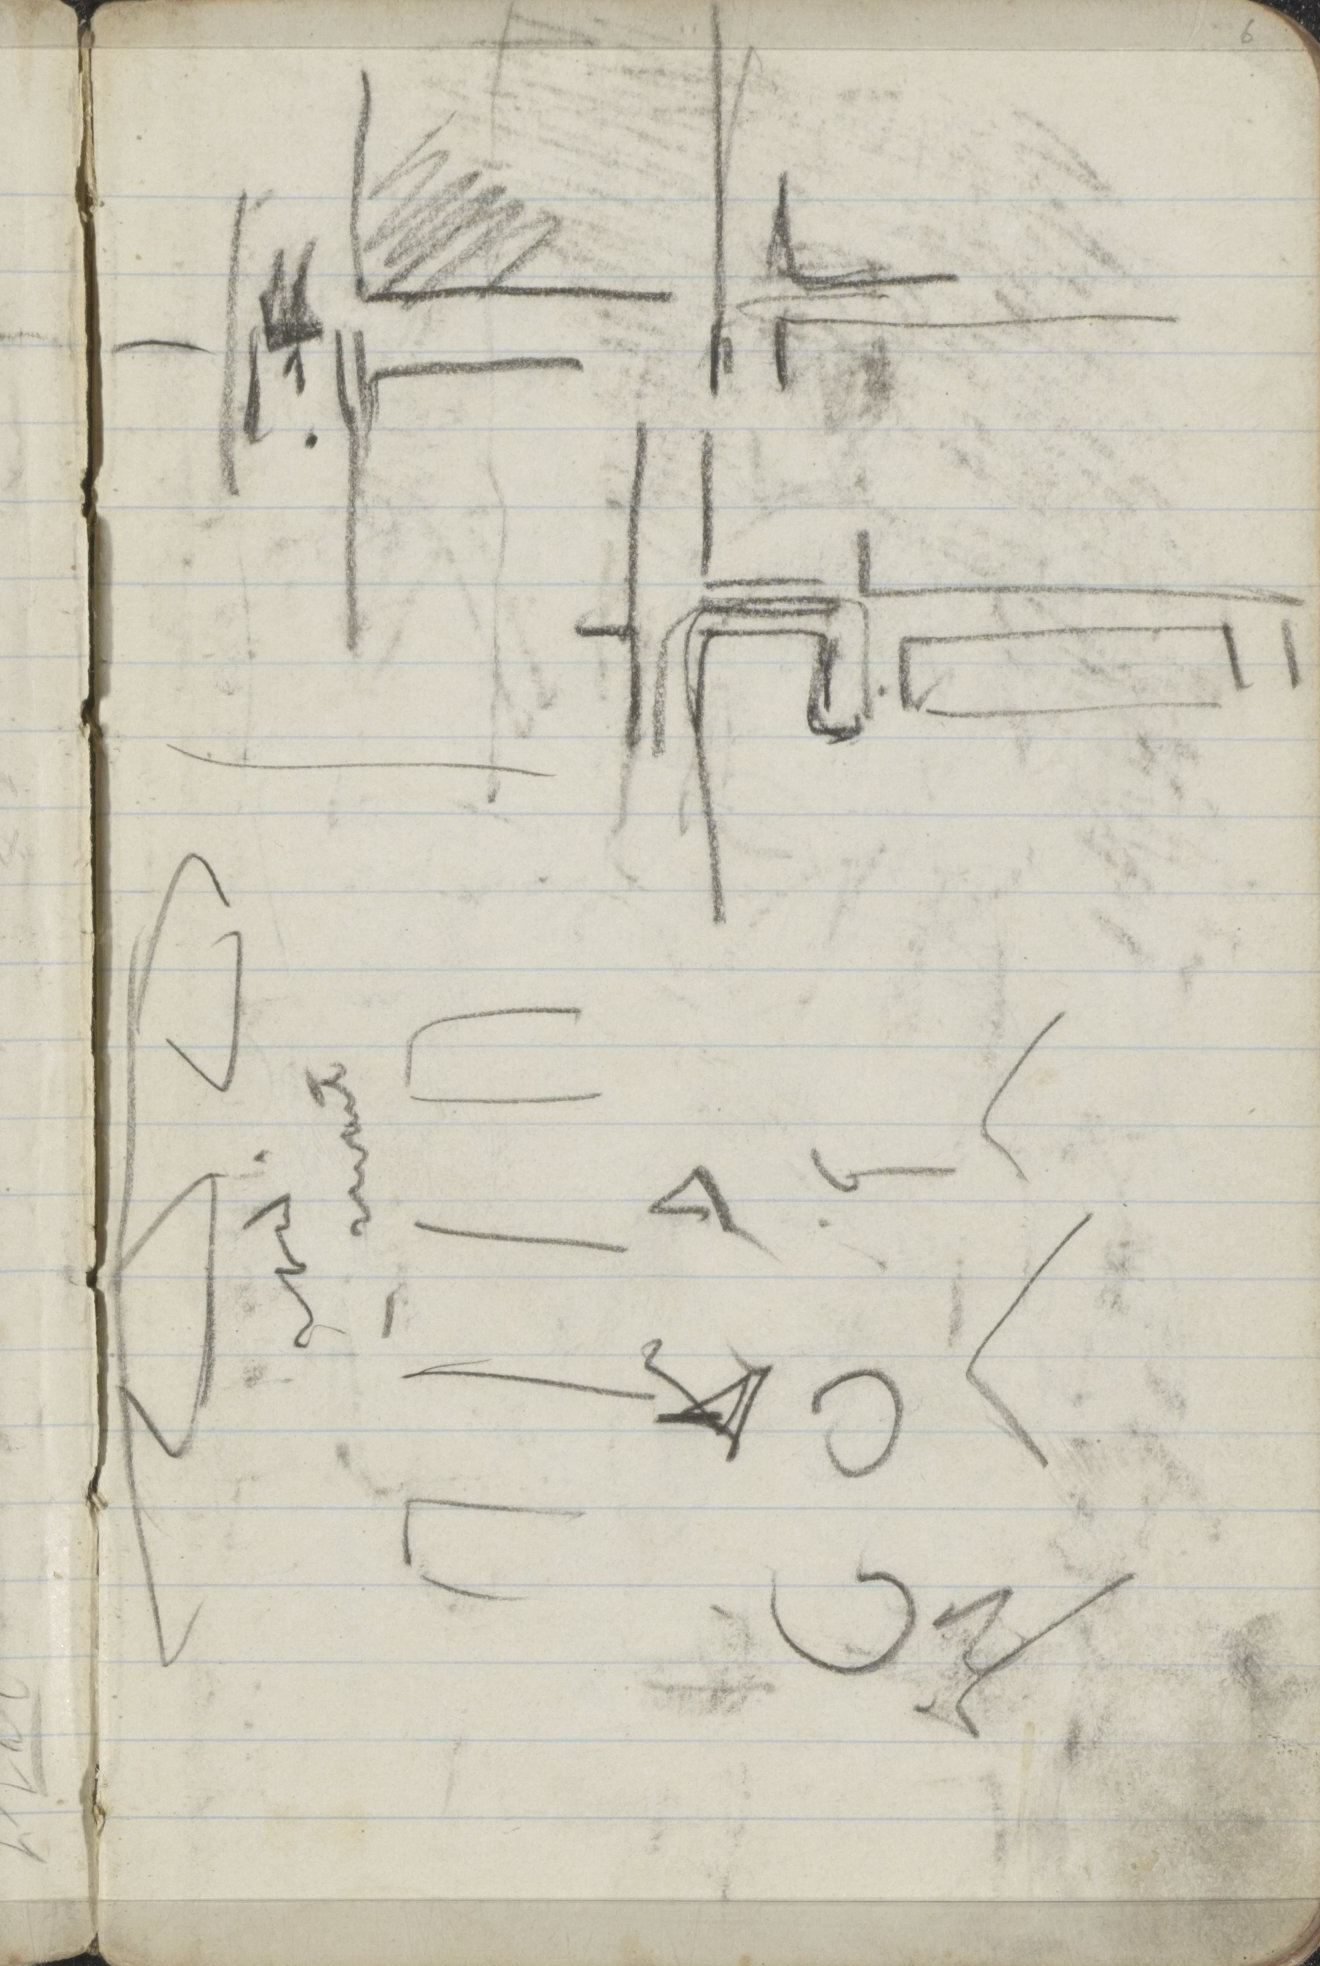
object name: sketchbook leaf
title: Studie, mogelijk van een gebouw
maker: george hendrik breitner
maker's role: draughtsman, painter, print maker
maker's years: 1857-1923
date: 1893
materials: chalk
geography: amsterdam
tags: architectural detail, civic architecture; edifices; dwellings, amsterdam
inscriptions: kleurnotitie, handgeschreven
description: Pagina 6 uit een schetsboek met 38 bladen.